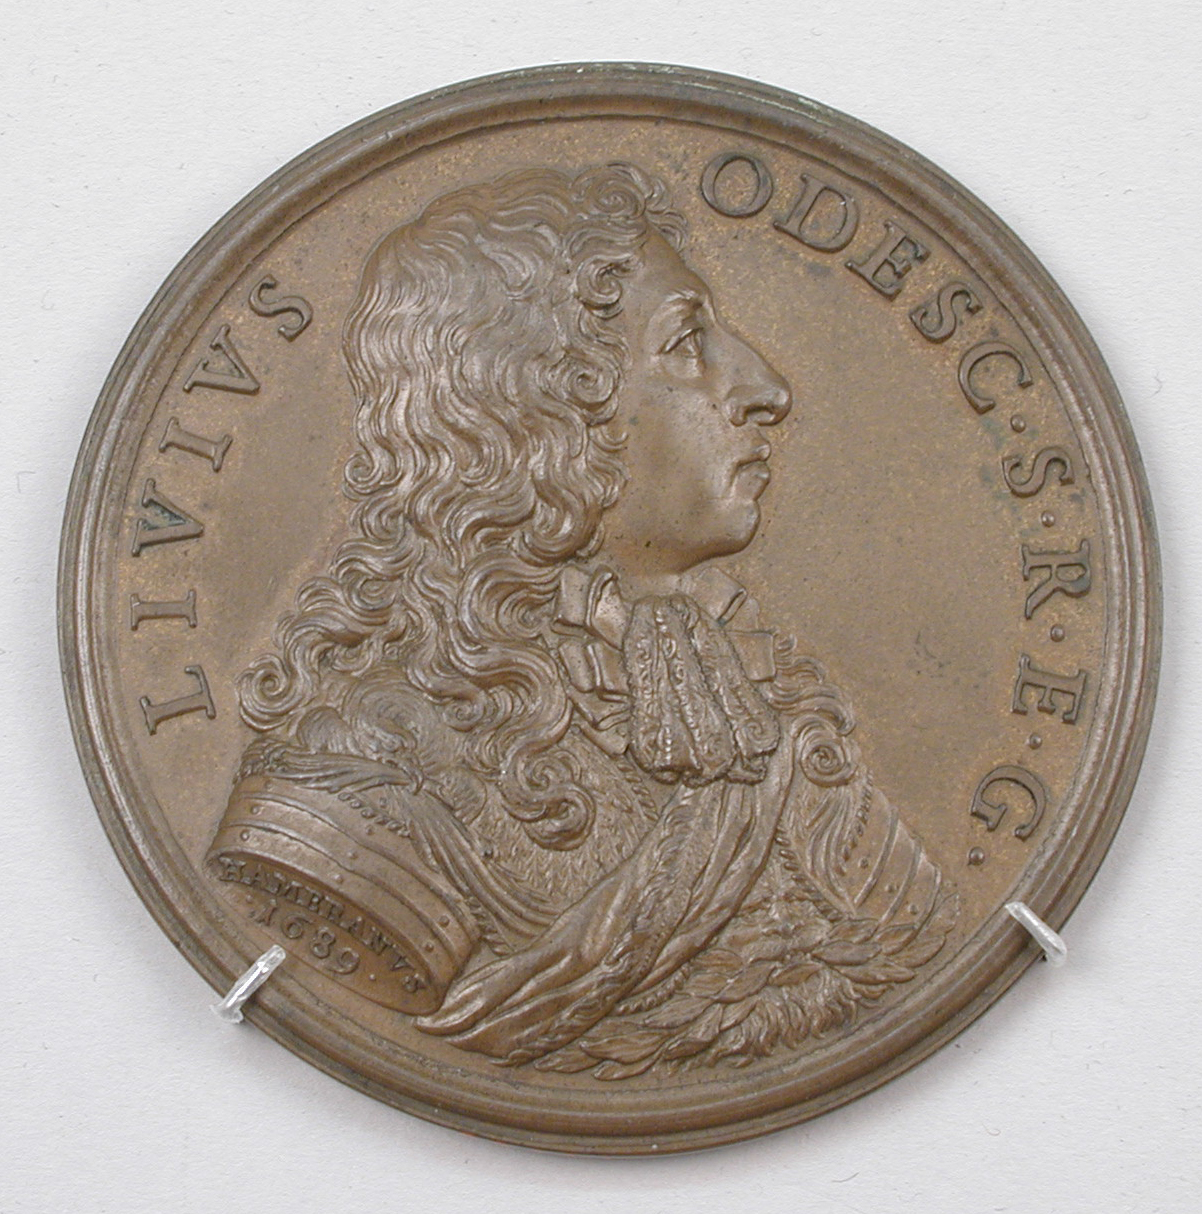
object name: medal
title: In honor of Livio Odescalchi, Gonfaloniere (Standard-Bearer) of the Holy Roman Church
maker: giovanni martino hamerani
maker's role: artist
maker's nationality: italian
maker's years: 1646-1705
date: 1689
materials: bronze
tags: men,profiles,sun